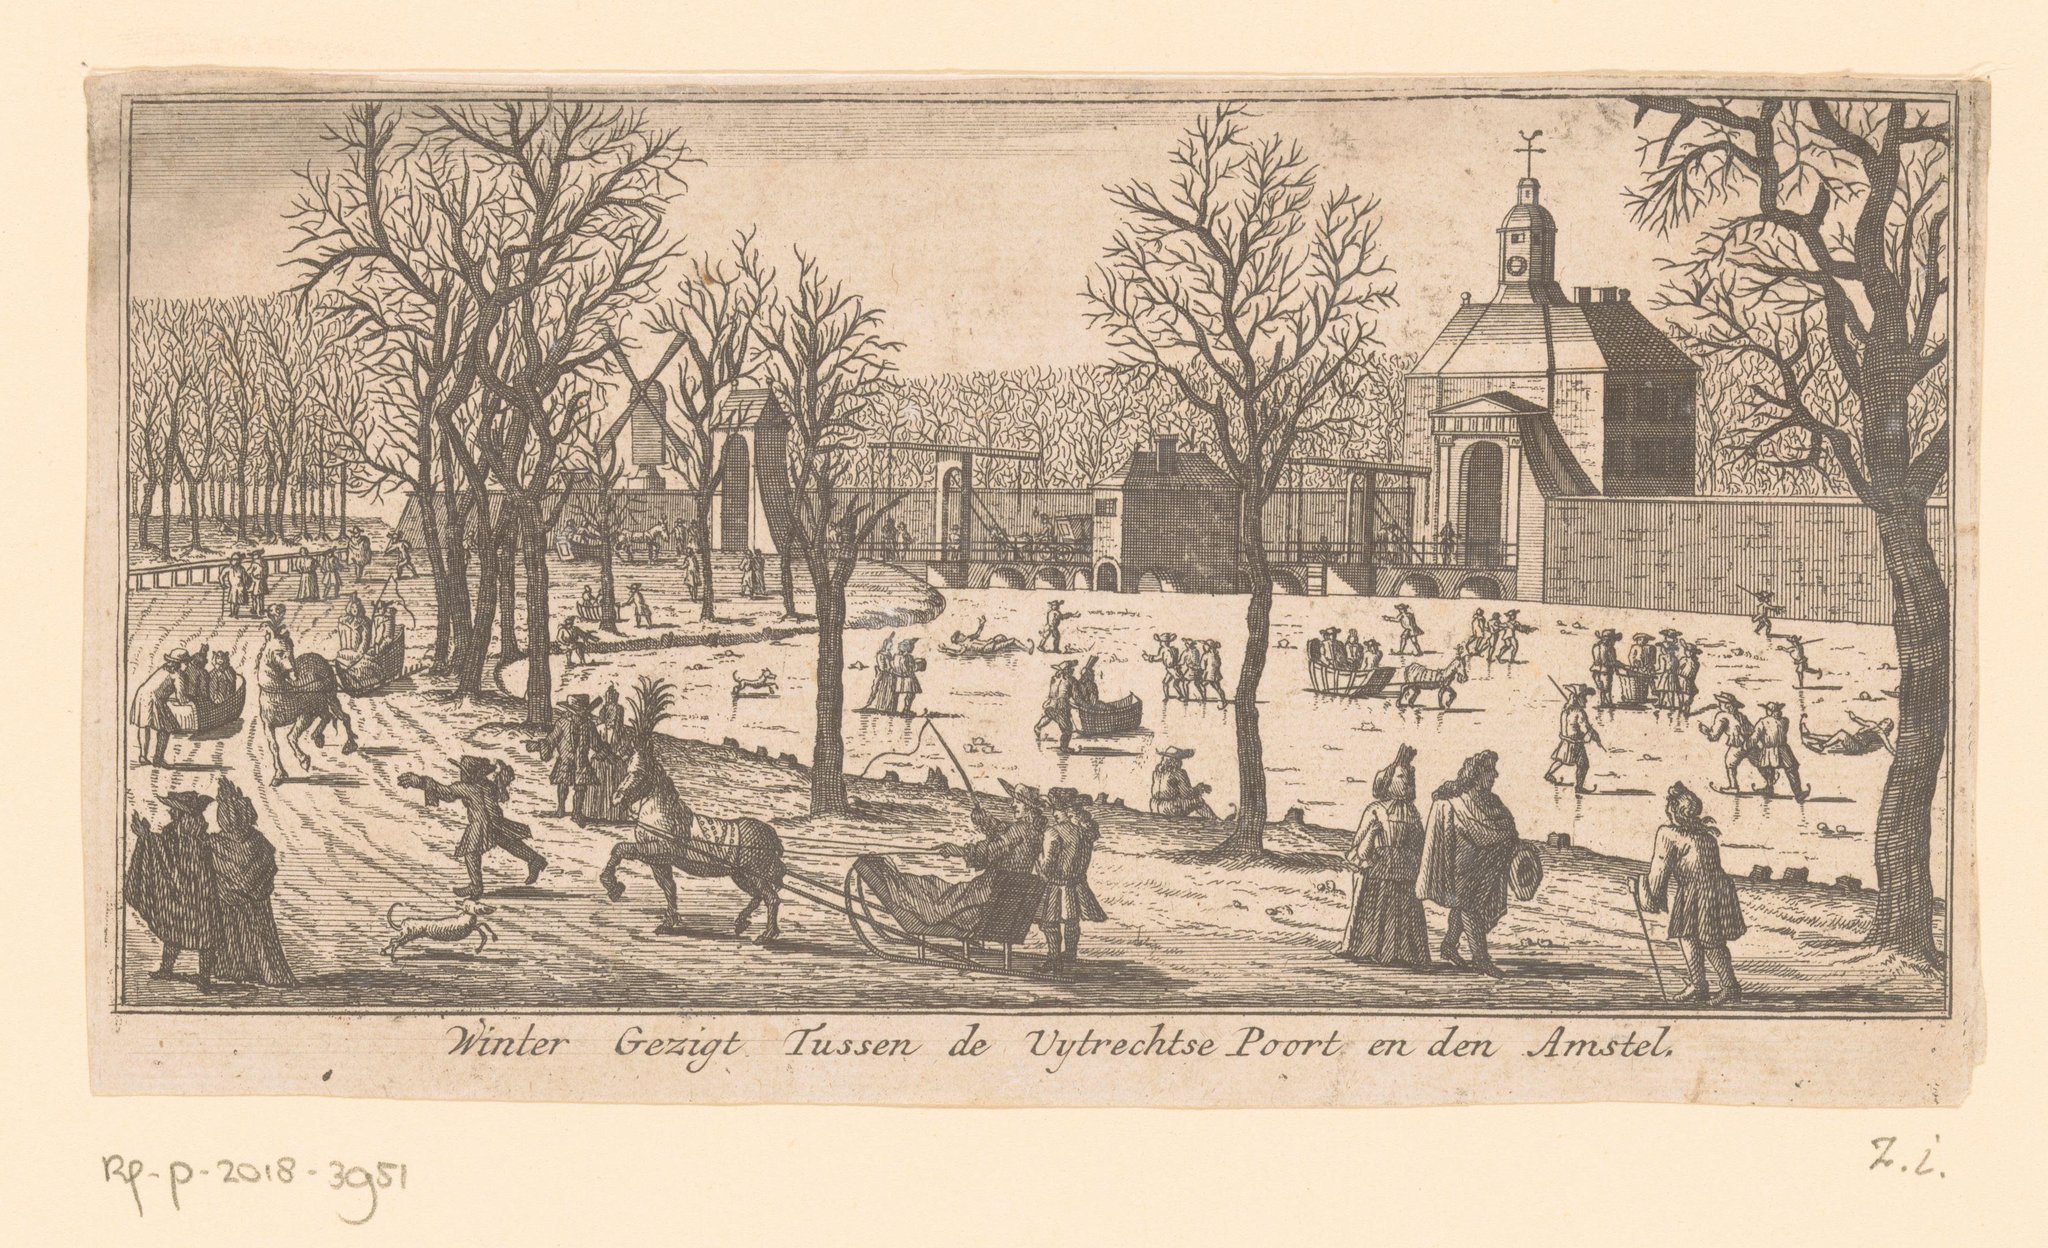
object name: print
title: Gezicht op de Utrechtsepoort in Amsterdam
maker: Anonymous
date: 1700-1750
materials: paper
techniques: engraving, etching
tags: sleigh, sledge (non-sport), skates (winter sports), bridge in city across river, canal, etc., city-gate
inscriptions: annotation: ‘N 13 (?)’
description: Voor een vergelijkbare prent, waarvan de bovenste helft van de plaat verdwenen is, maar de verdere afbeelding vrijwel identiek, zie RP-P-2018-3956. Deze prent heeft ook een ander opschrift. Onduidelijk is welke prent een kopie van welke is.